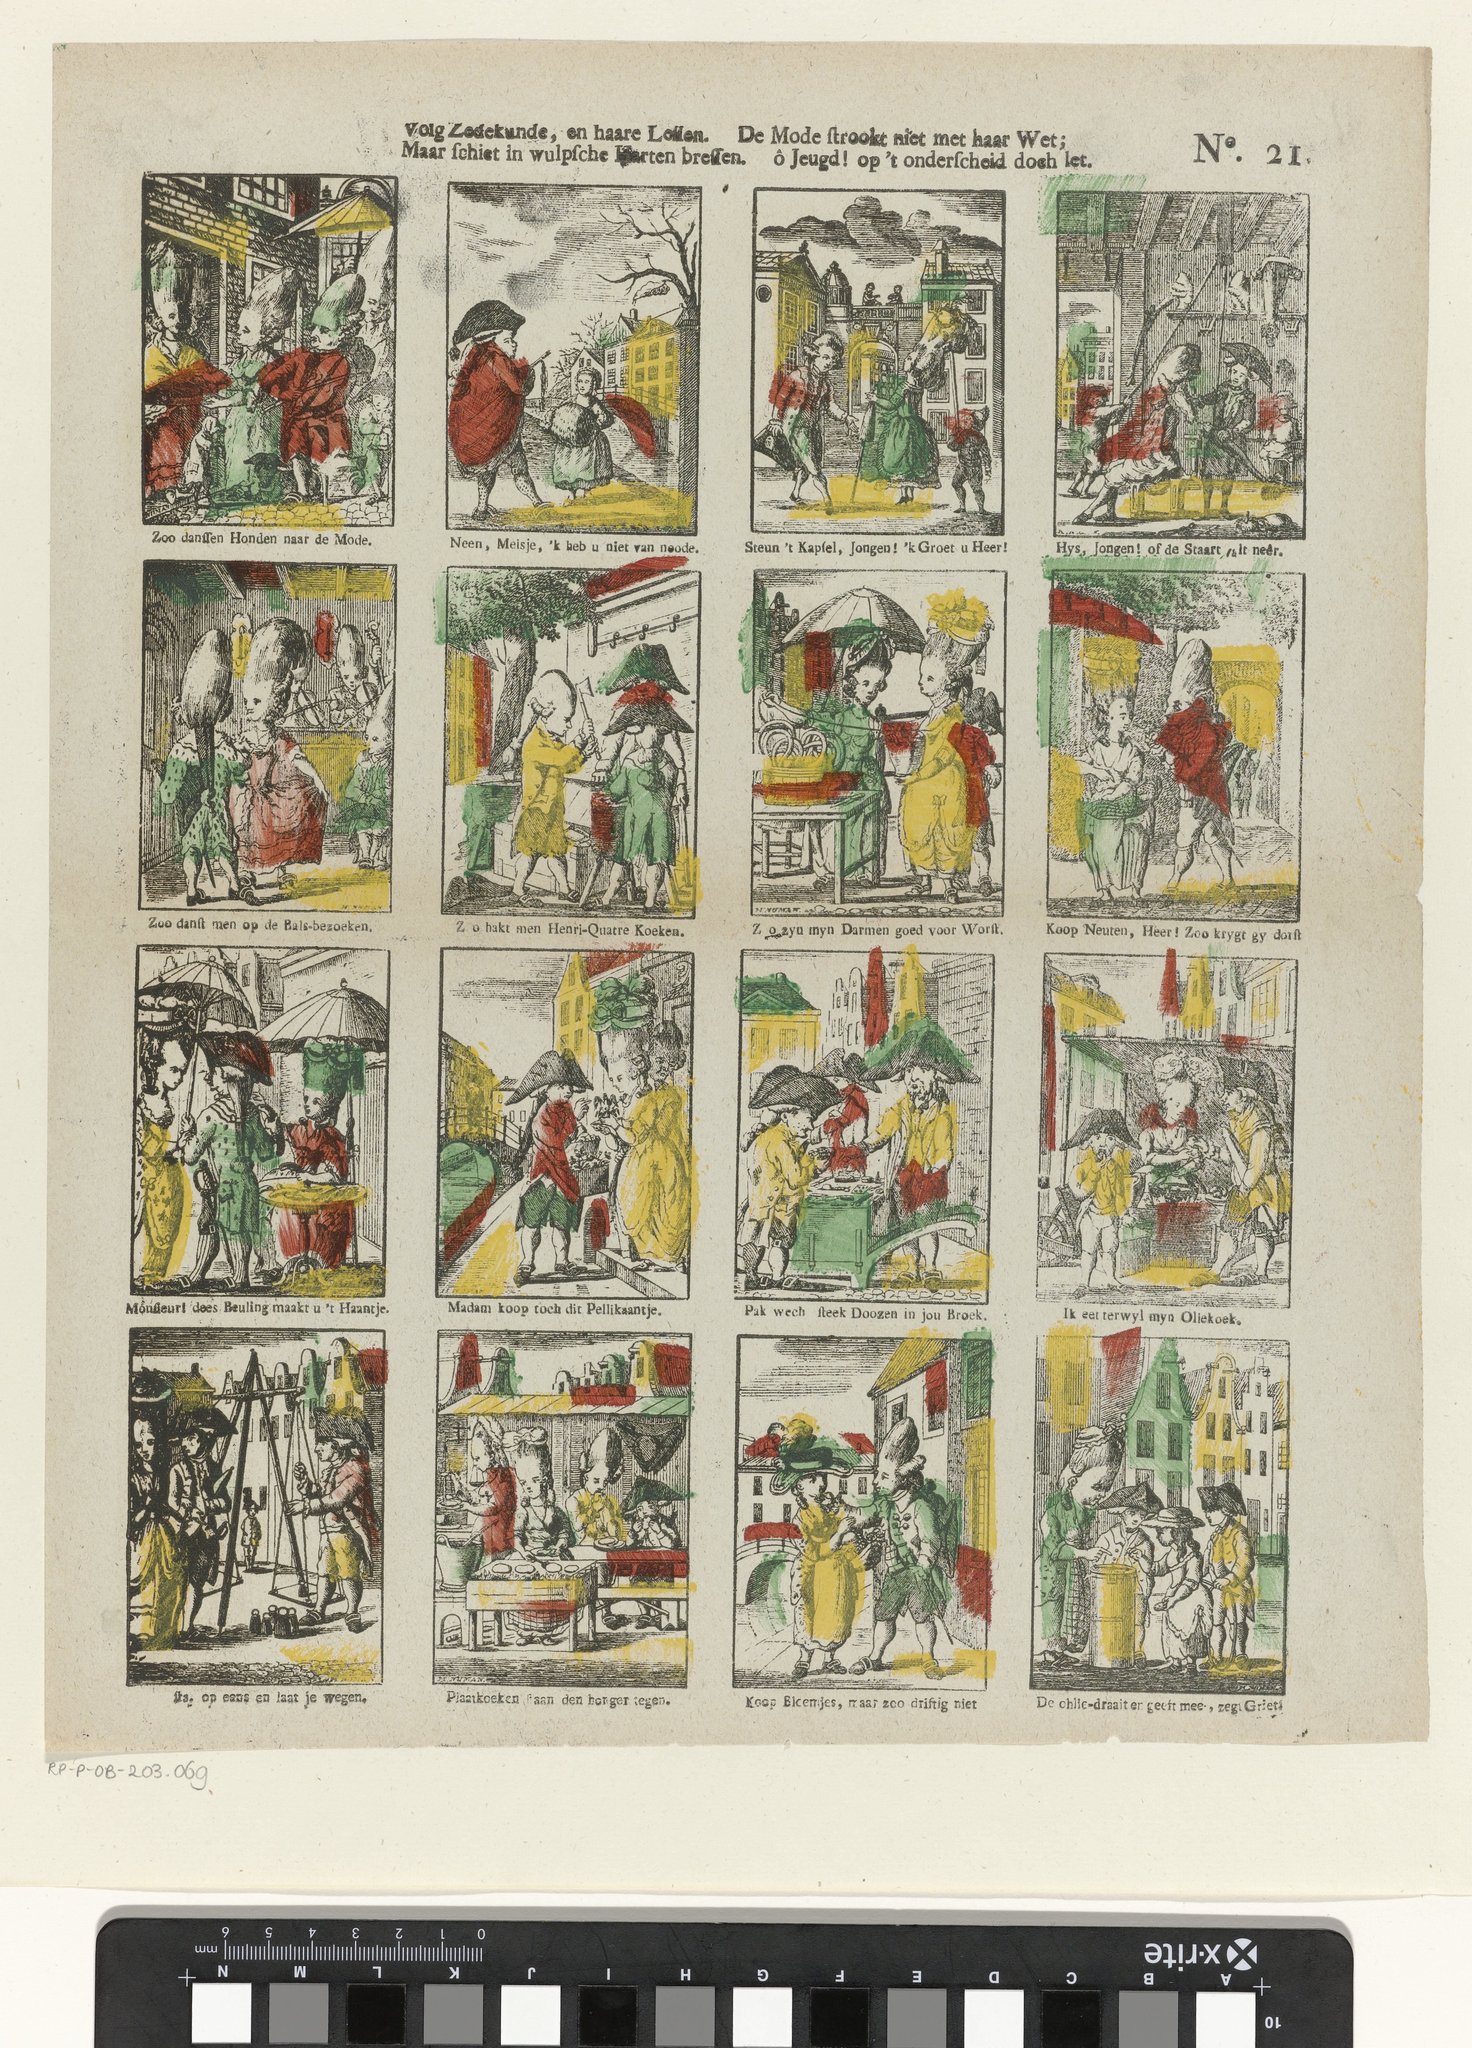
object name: cartoon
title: Volg zedekunde, en haar lessen. / Maar schiet in wulpsche harten bressen. / De mode strookt niet met haar wet; / ô jeugd! op 't onderscheid doch let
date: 1856-1900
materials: paper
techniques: colour, letterpress printing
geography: turnhout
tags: fashion, clothing, caricatures (human types), fashion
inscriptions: collector's mark: Lugt 2760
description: Spotprent op de mode met 16 voorstellingen over vreemde en te grote kledingstukken. Onder elke voorstelling een onderschrift. Genummerd rechtsboven: No. 21.